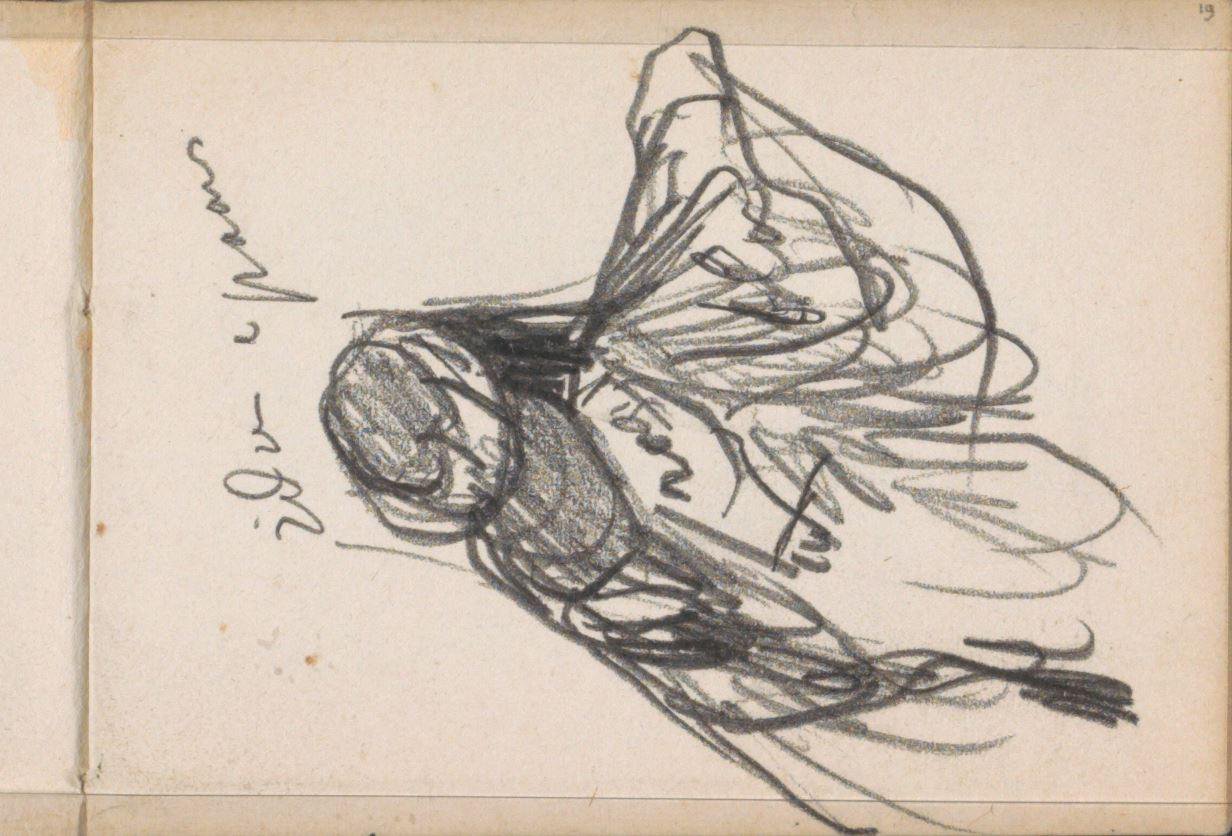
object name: sketchbook leaf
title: Figuur met een hoofddoek, op de rug gezien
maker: marius bauer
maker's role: draughtsman, print maker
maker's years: 1867-1932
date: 1922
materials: paper, pencil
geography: biskra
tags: head-gear (with name), africans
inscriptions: kleurnotitie, handgeschreven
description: Pagina 19 uit een schetsboek met 32 bladen.